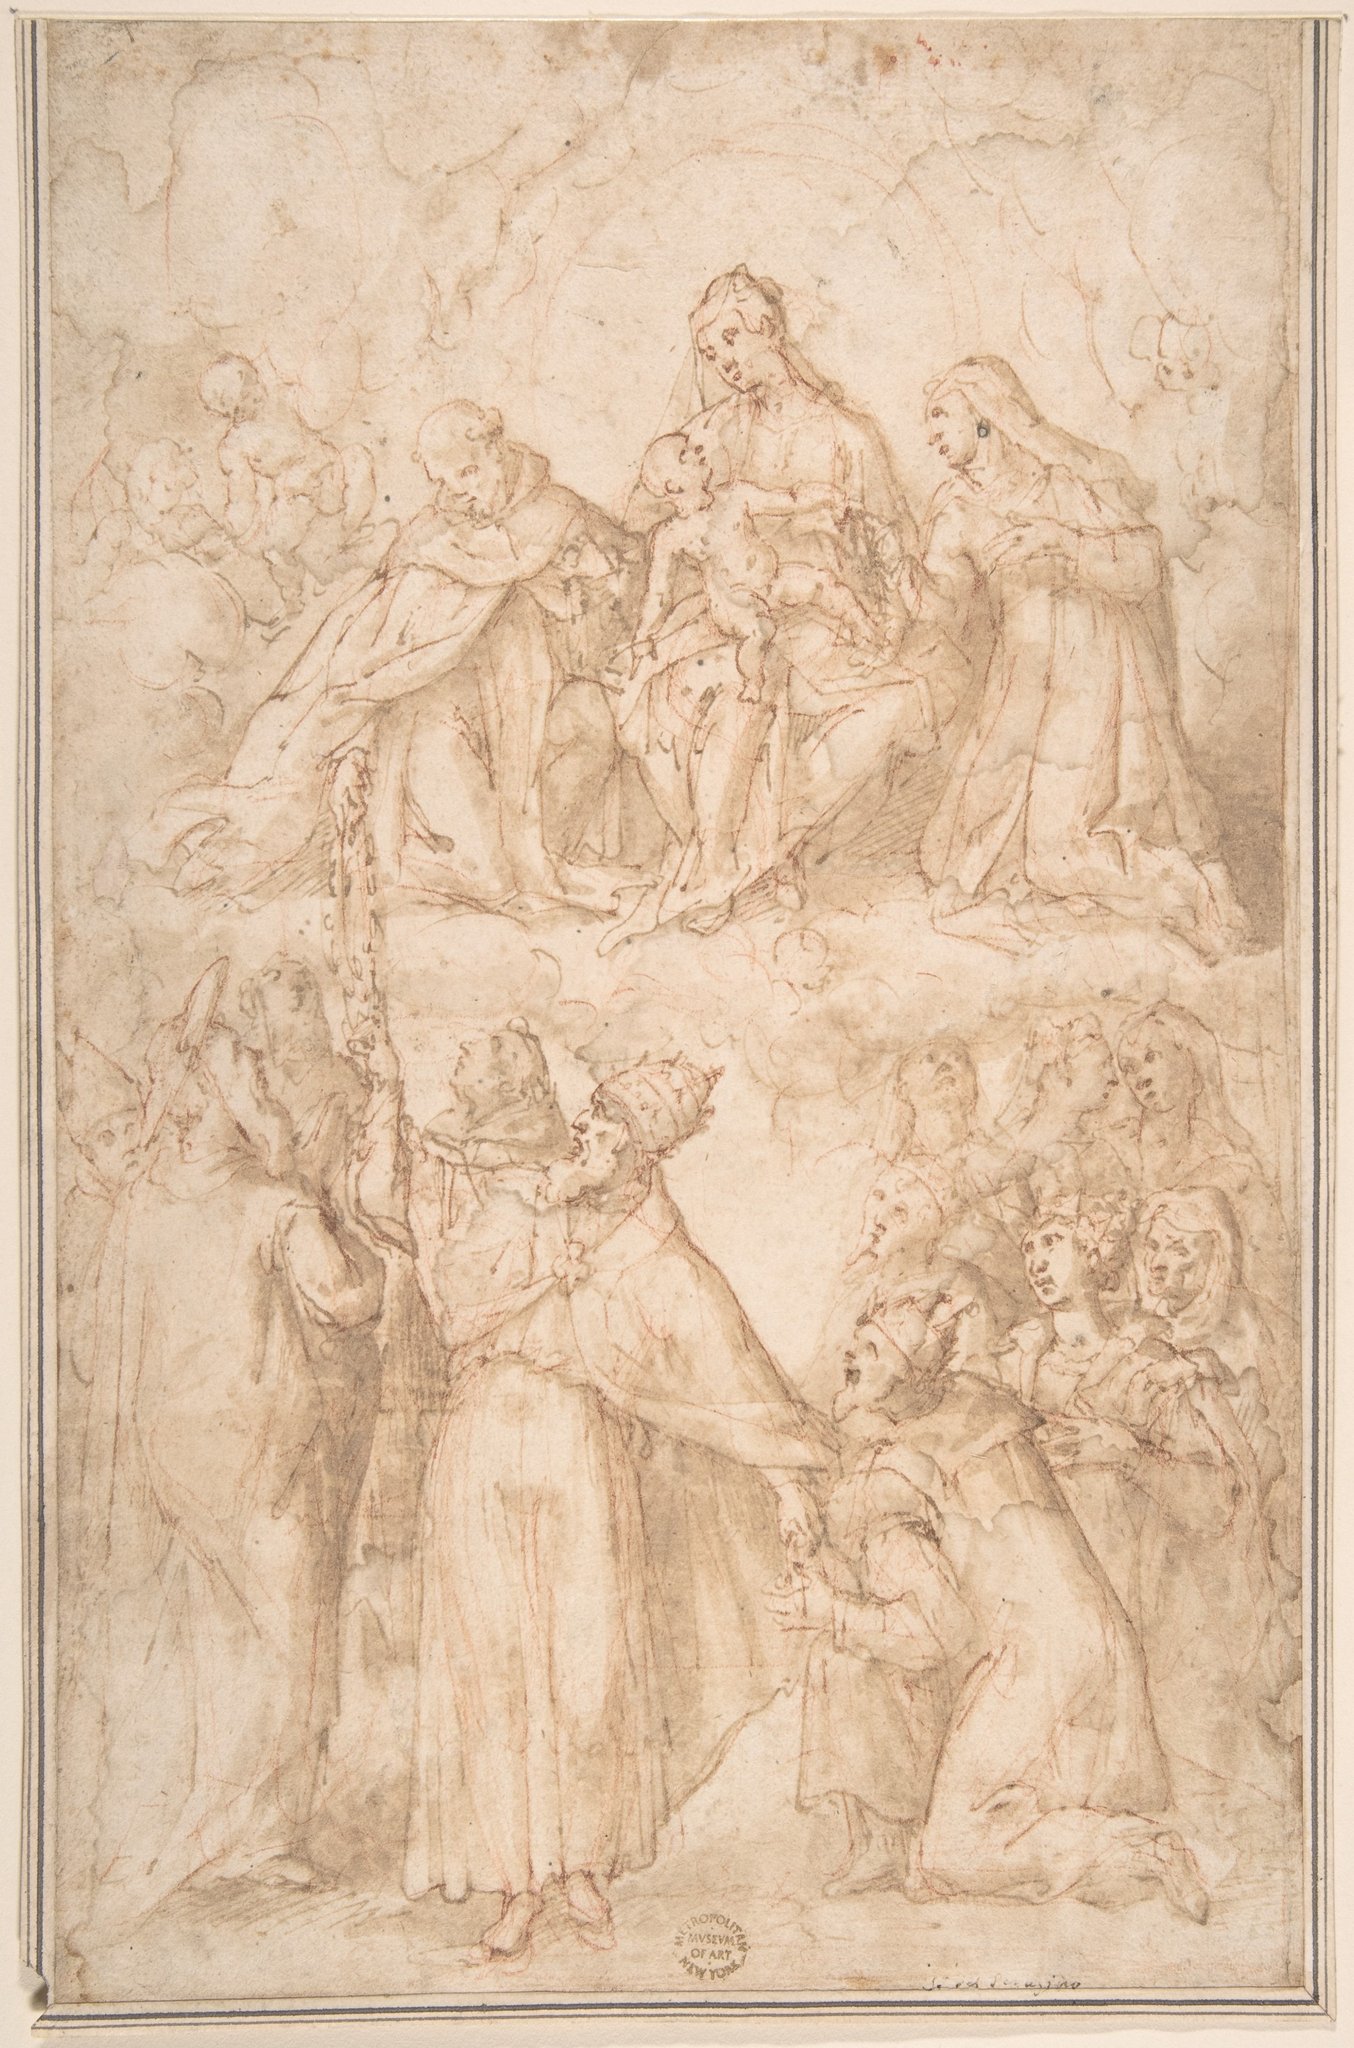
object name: drawing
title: Saint Dominic Giving the Rosary to Pope Pius V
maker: anonymous, italian, roman-bolognese, 17th century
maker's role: artist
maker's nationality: italian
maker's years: 1600-1700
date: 1601-1700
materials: chalk, ink, paper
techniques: brush, pen, wash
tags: infants,popes,saints